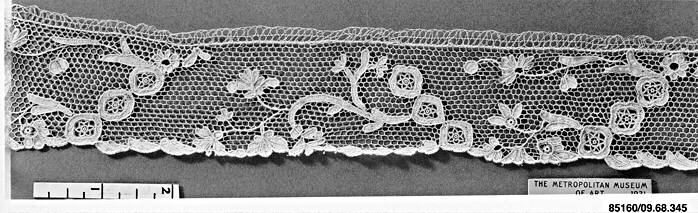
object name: strip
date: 1701-1800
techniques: lace